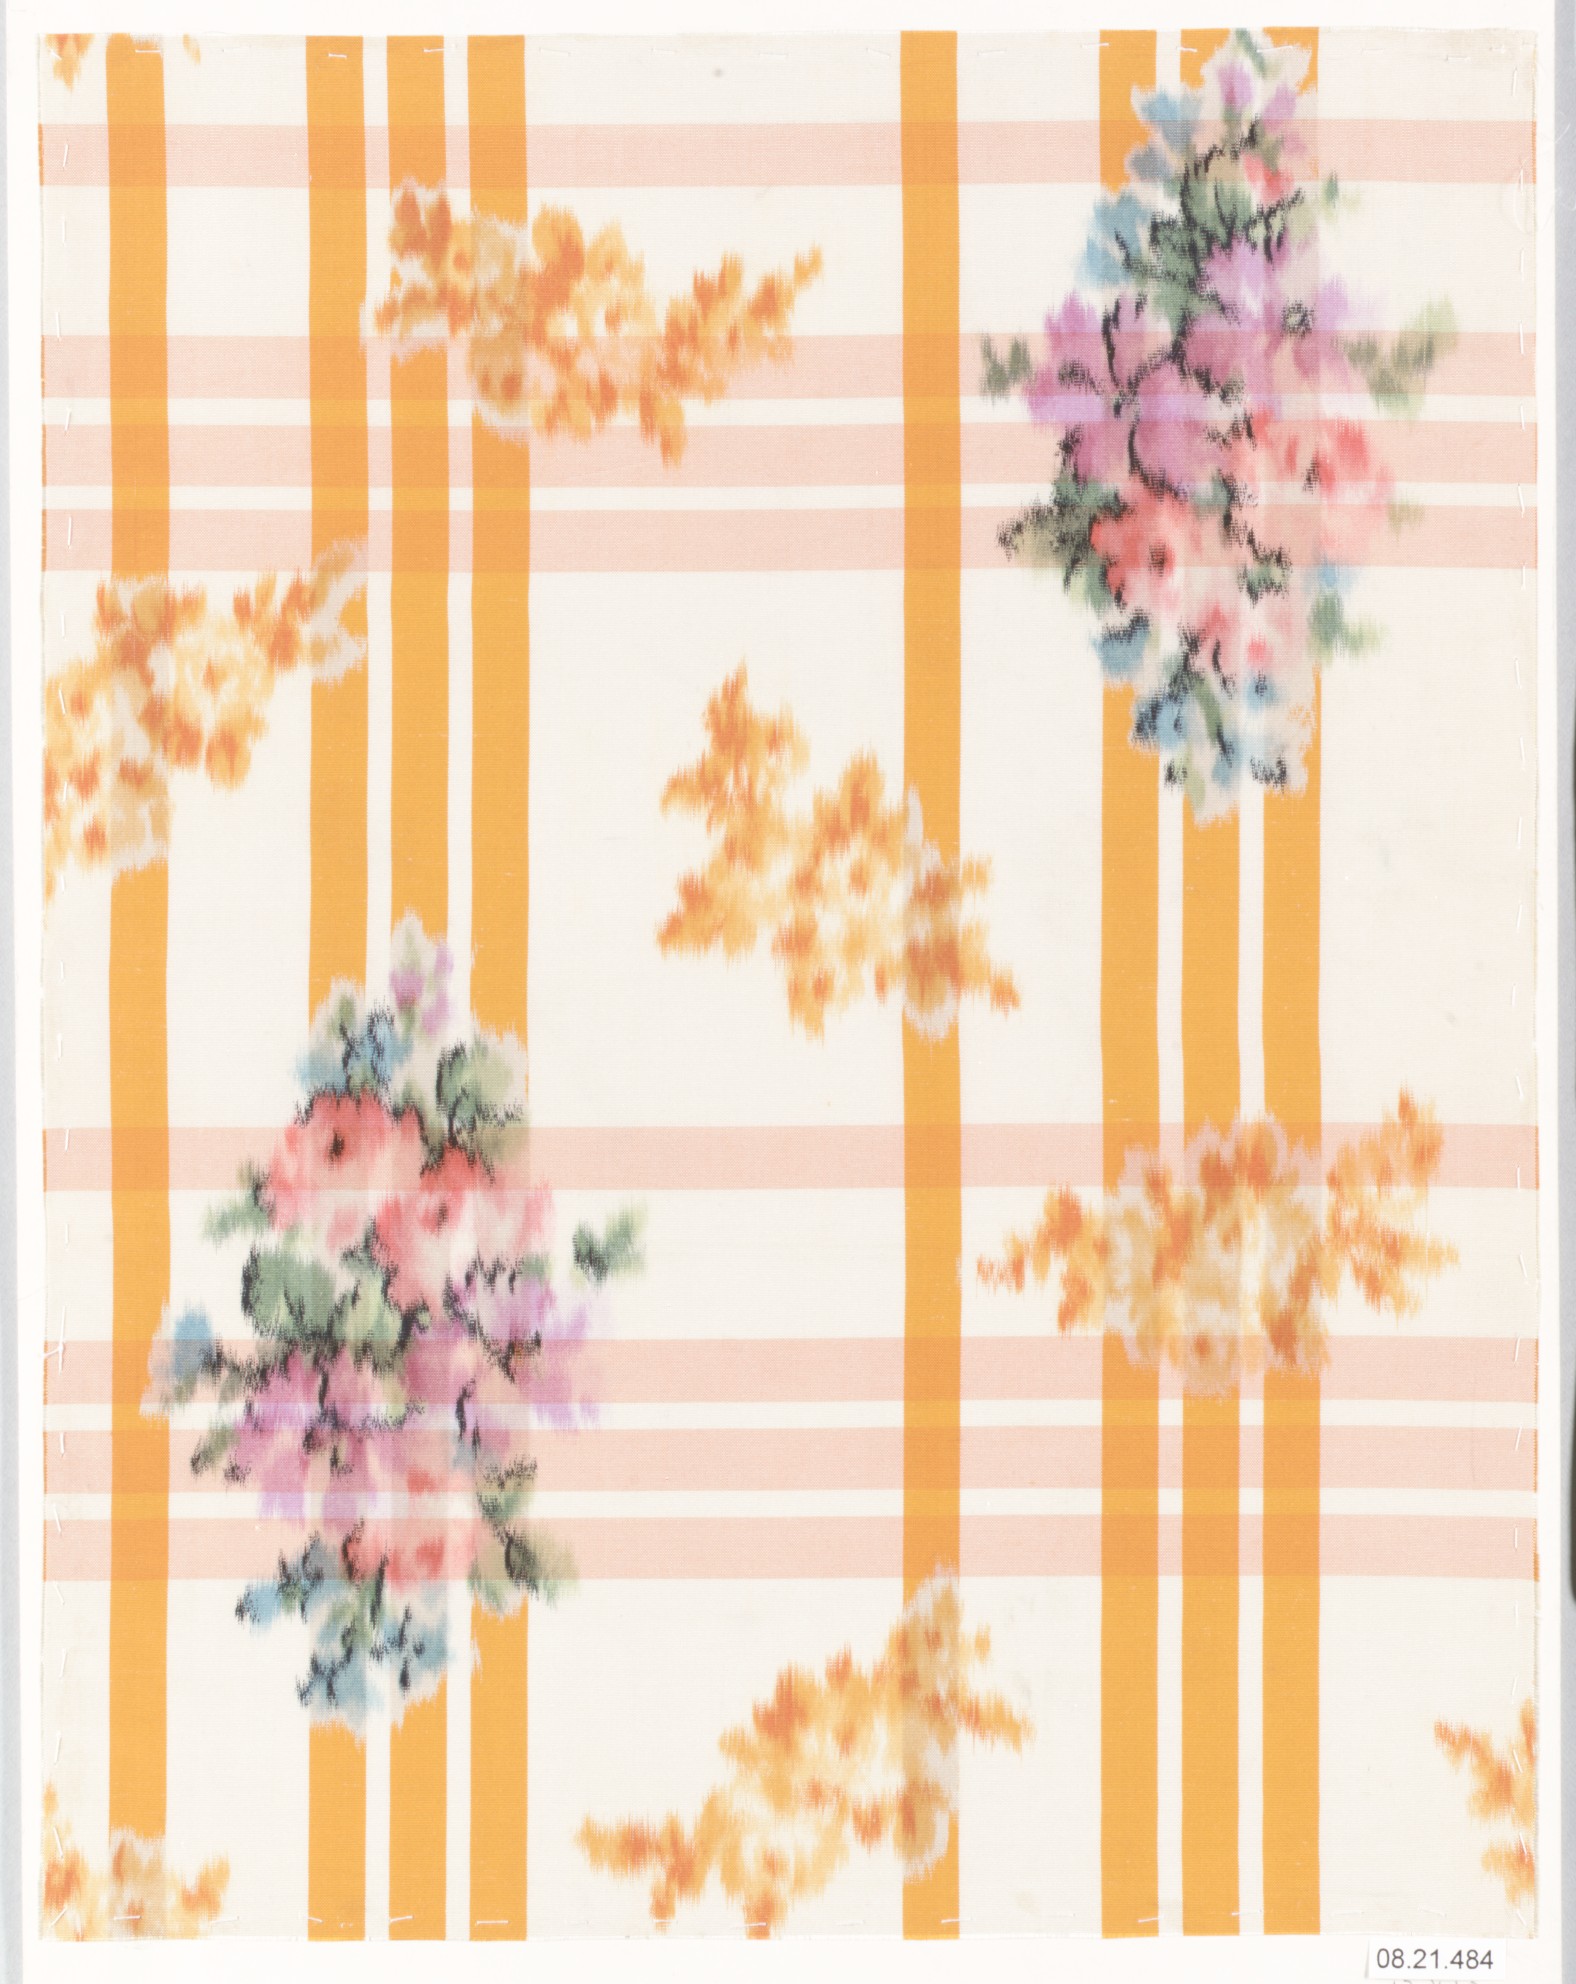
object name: textile sample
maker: Anonymous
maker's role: designer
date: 1900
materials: silk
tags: flowers